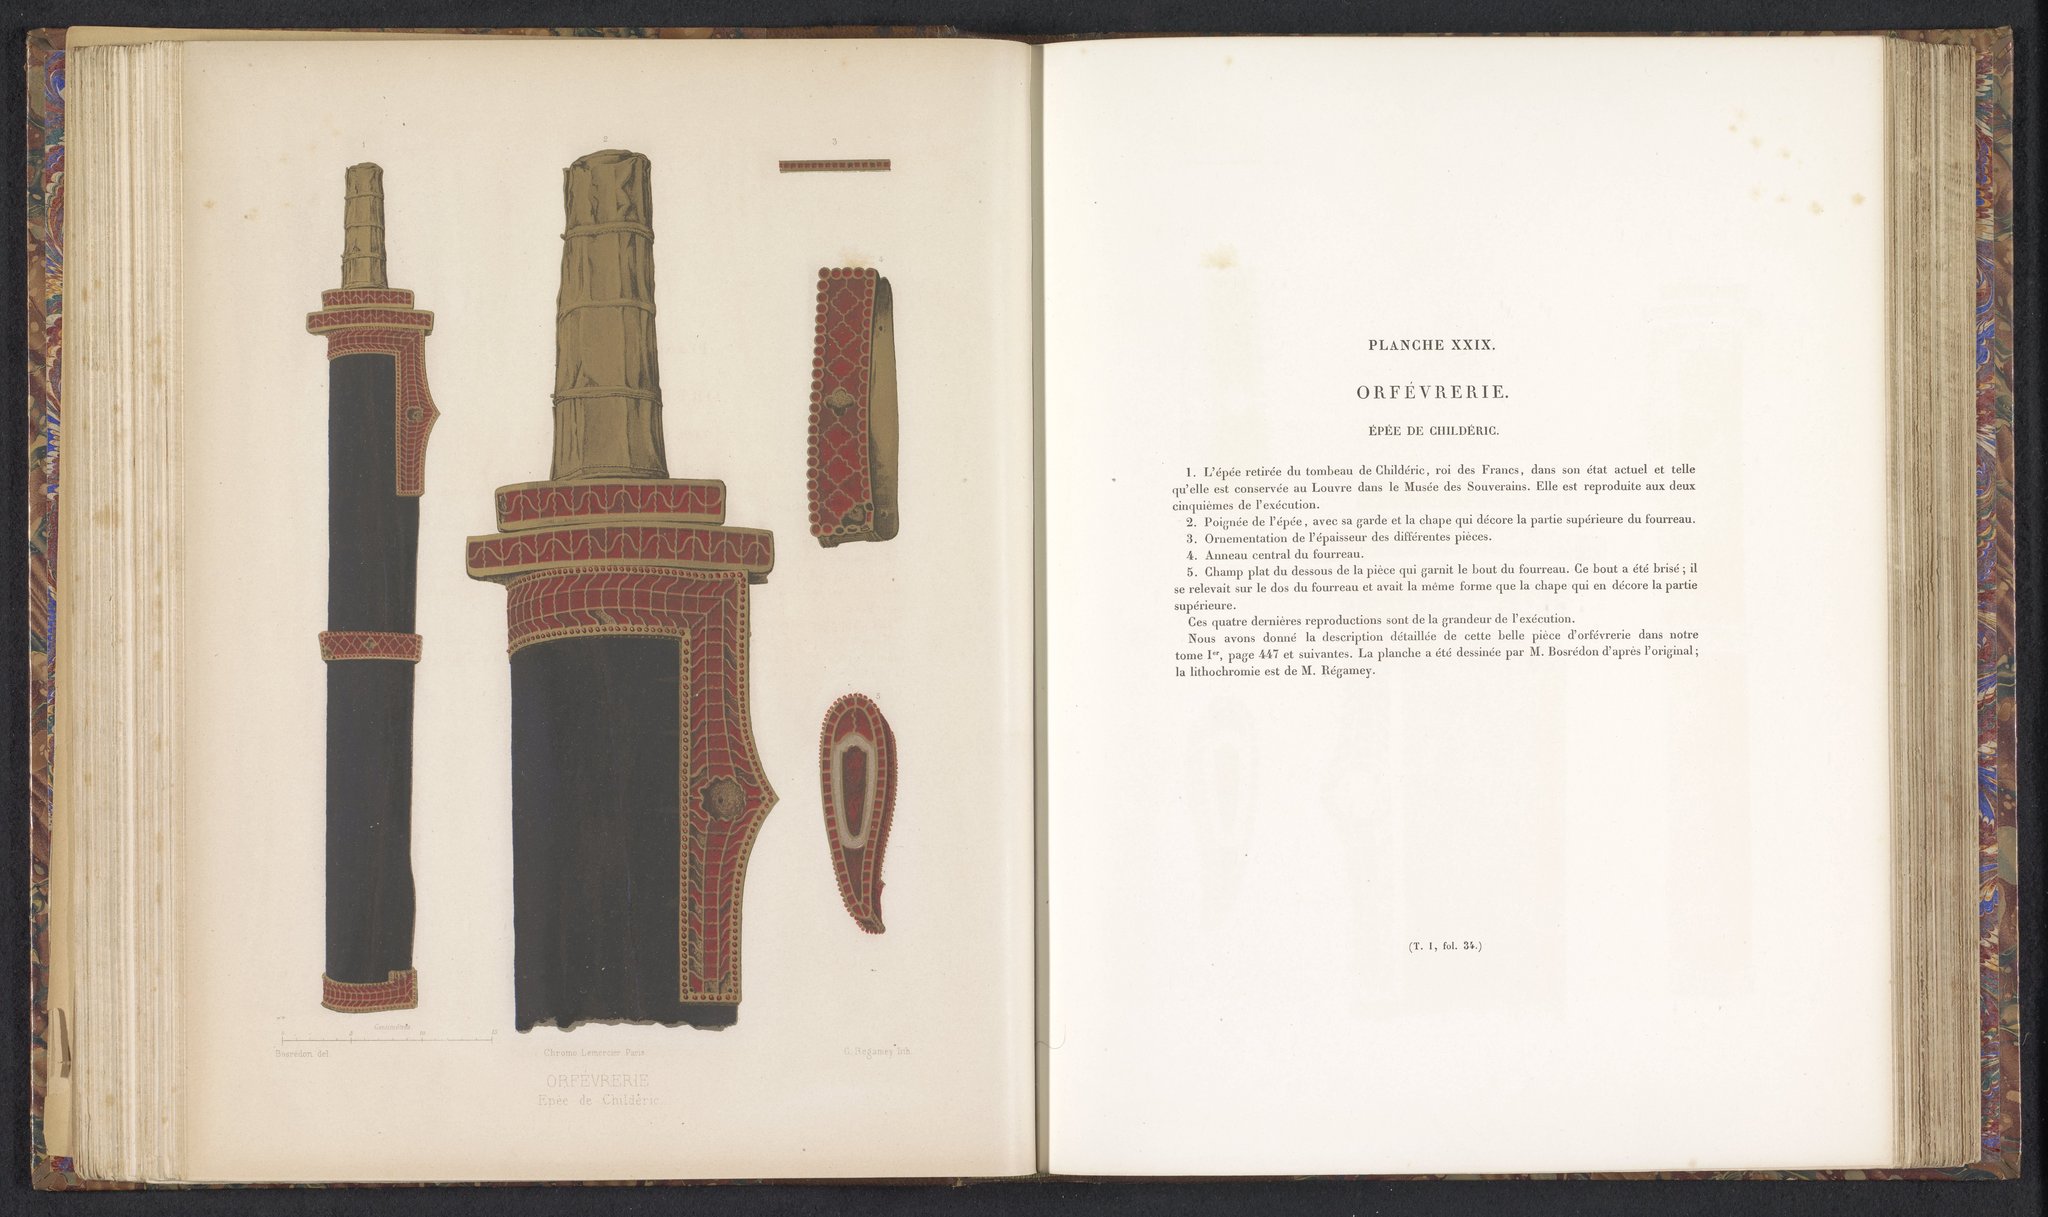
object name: print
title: Orfévrerie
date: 1859-1864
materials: paper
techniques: lithograph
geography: paris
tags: hacking and thrusting weapons: sword